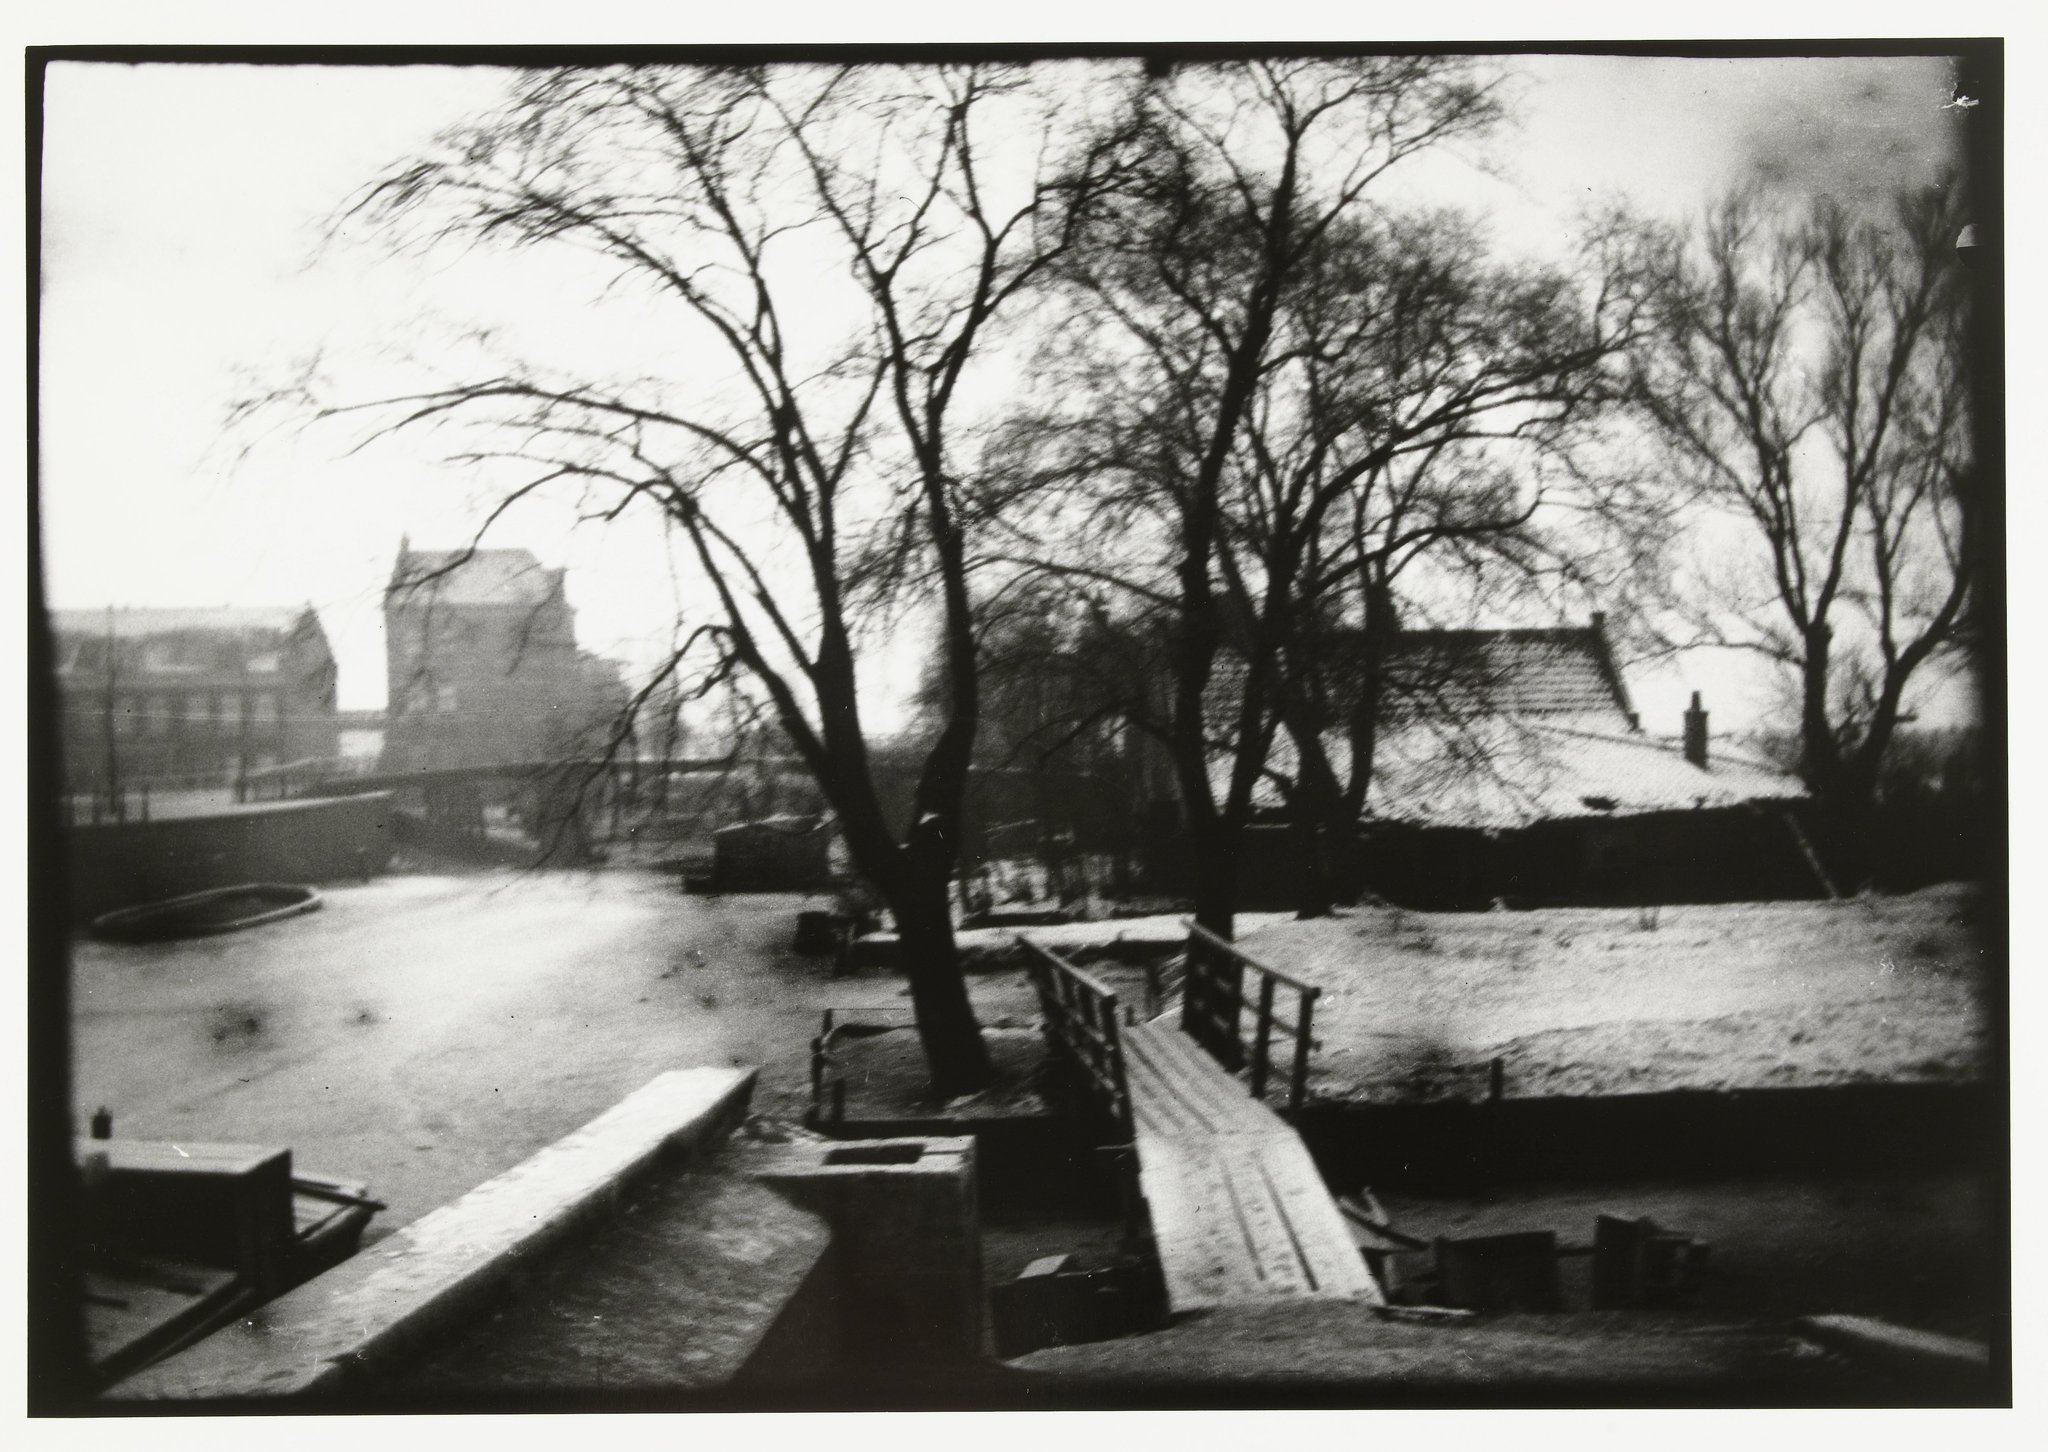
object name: photograph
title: Wintergezicht over de Amstel in Amsterdam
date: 1890-1910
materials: paper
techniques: gelatin silver print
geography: amsterdam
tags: amsterdam